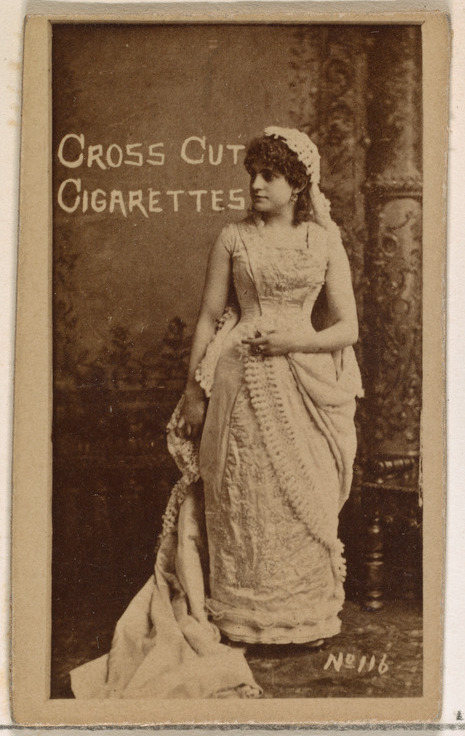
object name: print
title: Card Number 116, from the Actors and Actresses series (N145-1) issued by Duke Sons & Co. to promote Cross Cut Cigarettes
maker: w. duke, sons & co.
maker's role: publisher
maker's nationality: american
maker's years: 1870-1920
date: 1880-1889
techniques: albumen silver print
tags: portraits,women,actresses